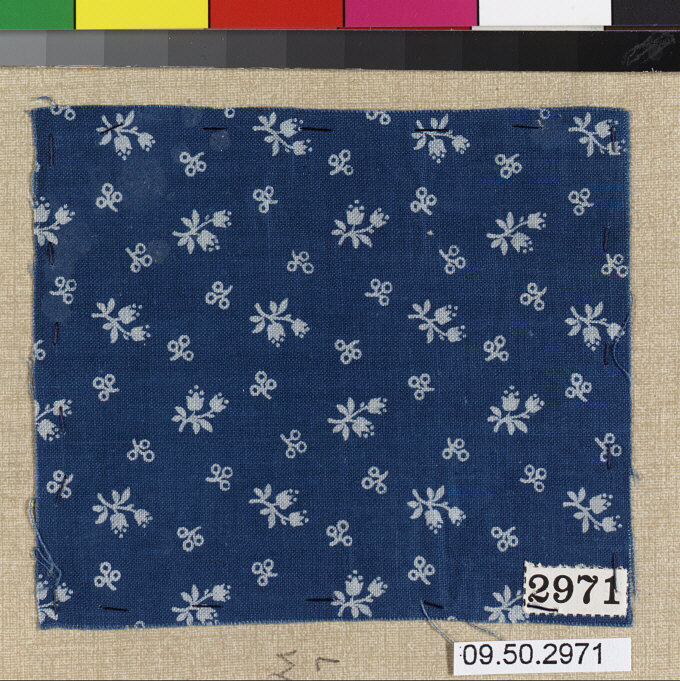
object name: piece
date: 1801-1900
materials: cotton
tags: flowers,leaves